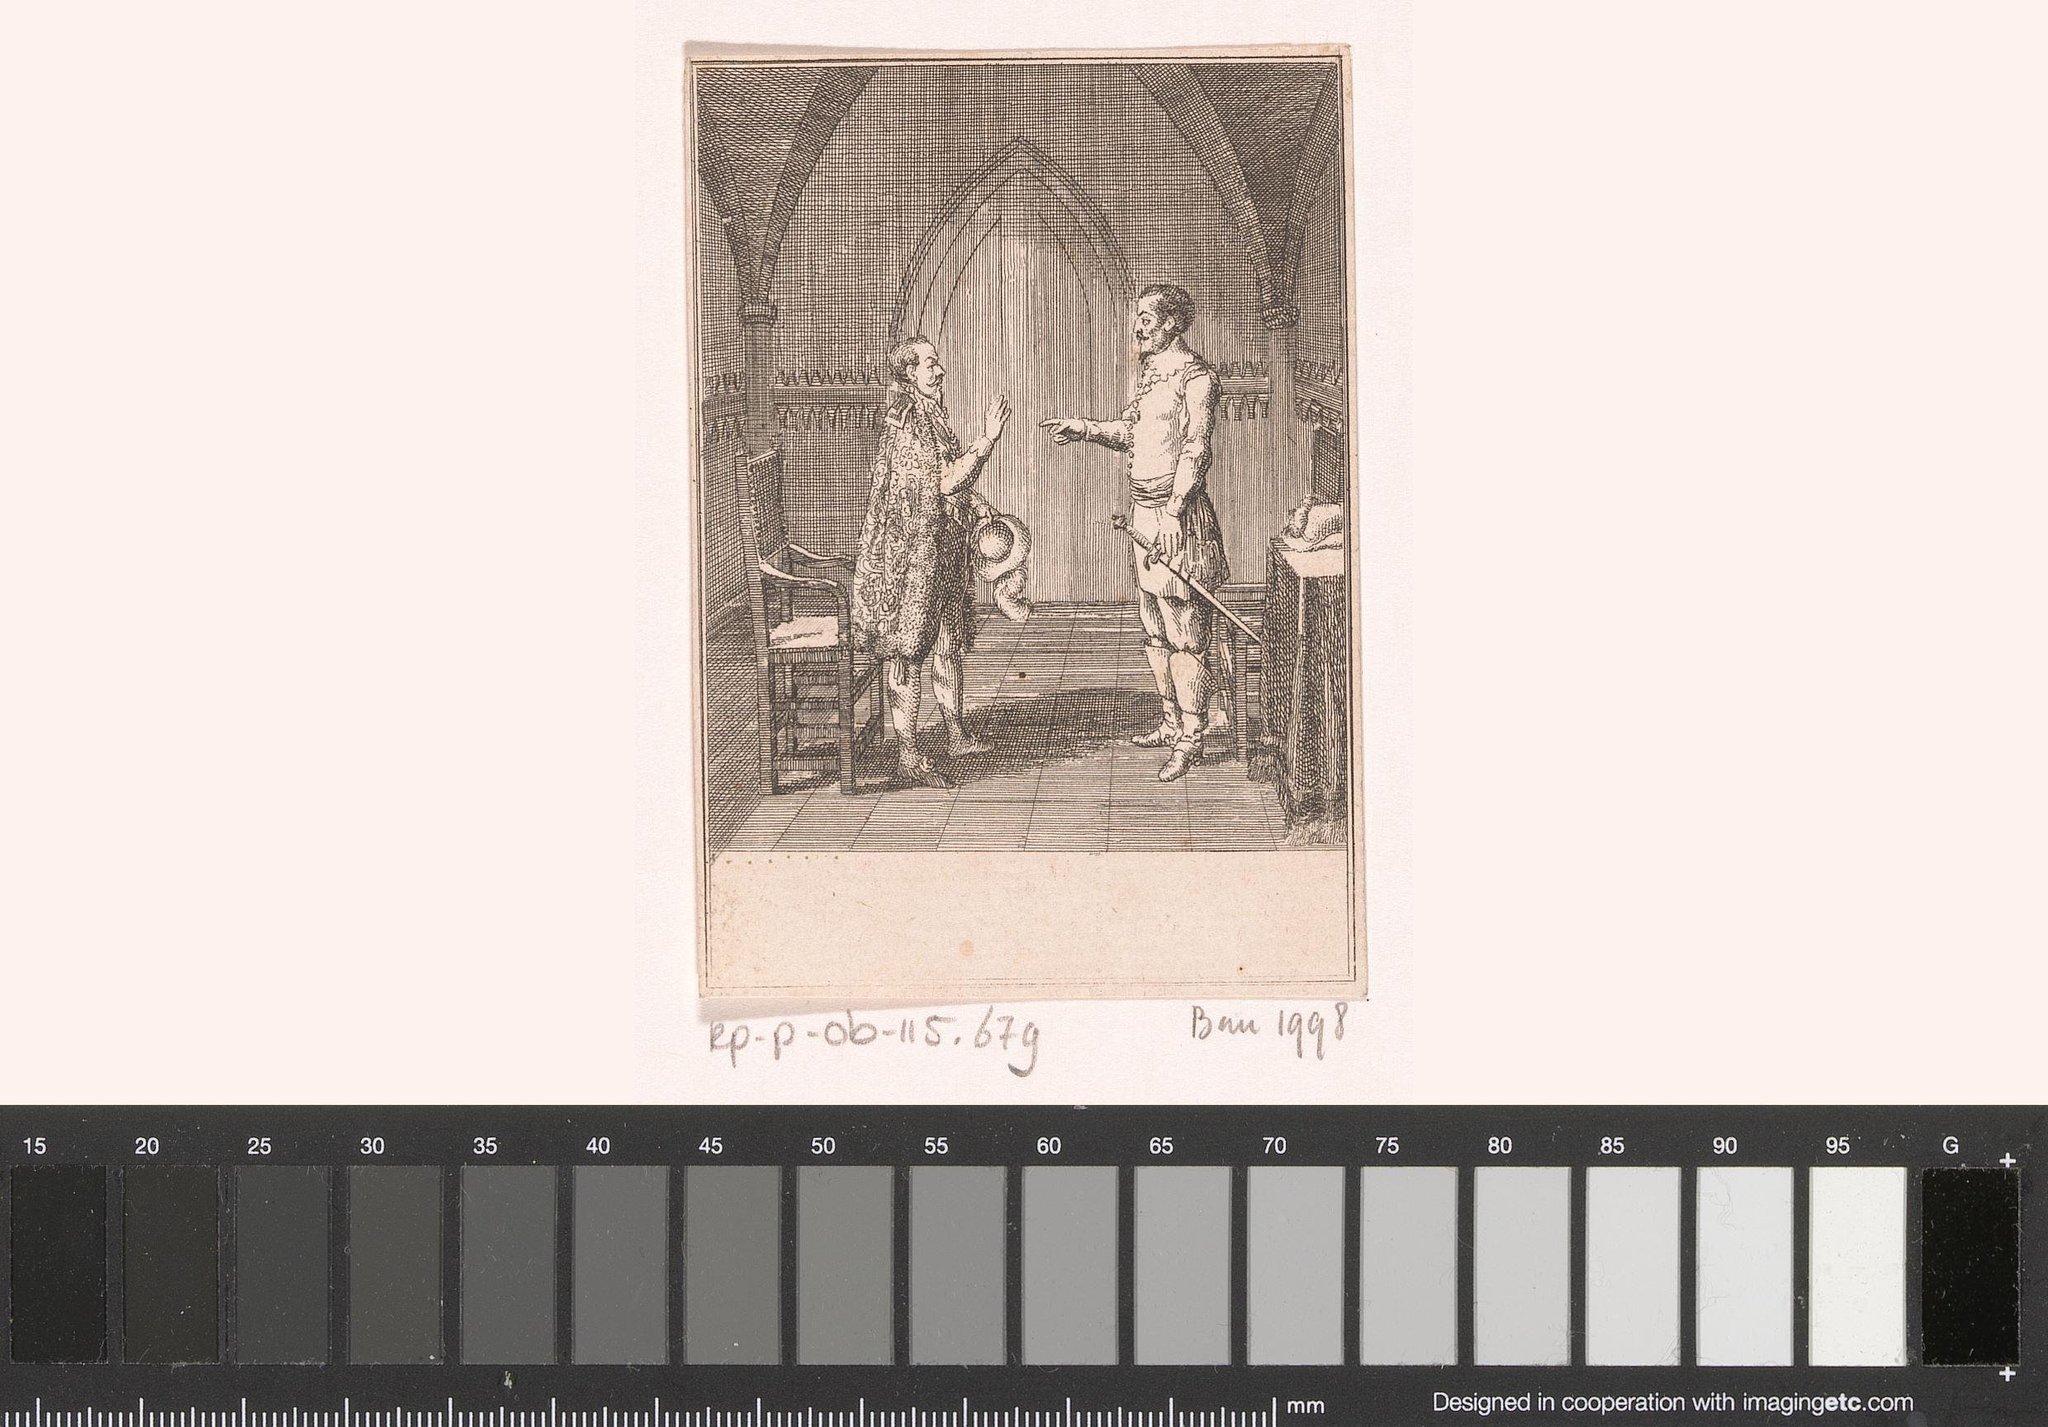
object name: print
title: Wallenstein in gesprek met Eggenberg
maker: daniel nikolaus chodowiecki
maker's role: draughtsman, print maker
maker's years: 1726-1801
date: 1799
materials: paper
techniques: etching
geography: berlin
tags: meeting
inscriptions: collector's mark: Lugt 2228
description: Prent gebruikt voor: Woltmann, Karl Ludwig von. Historischer Kalender auf das Gemein-Jahr 1803 (...). Berlijn: Johann Friedrich Unger, s.a.